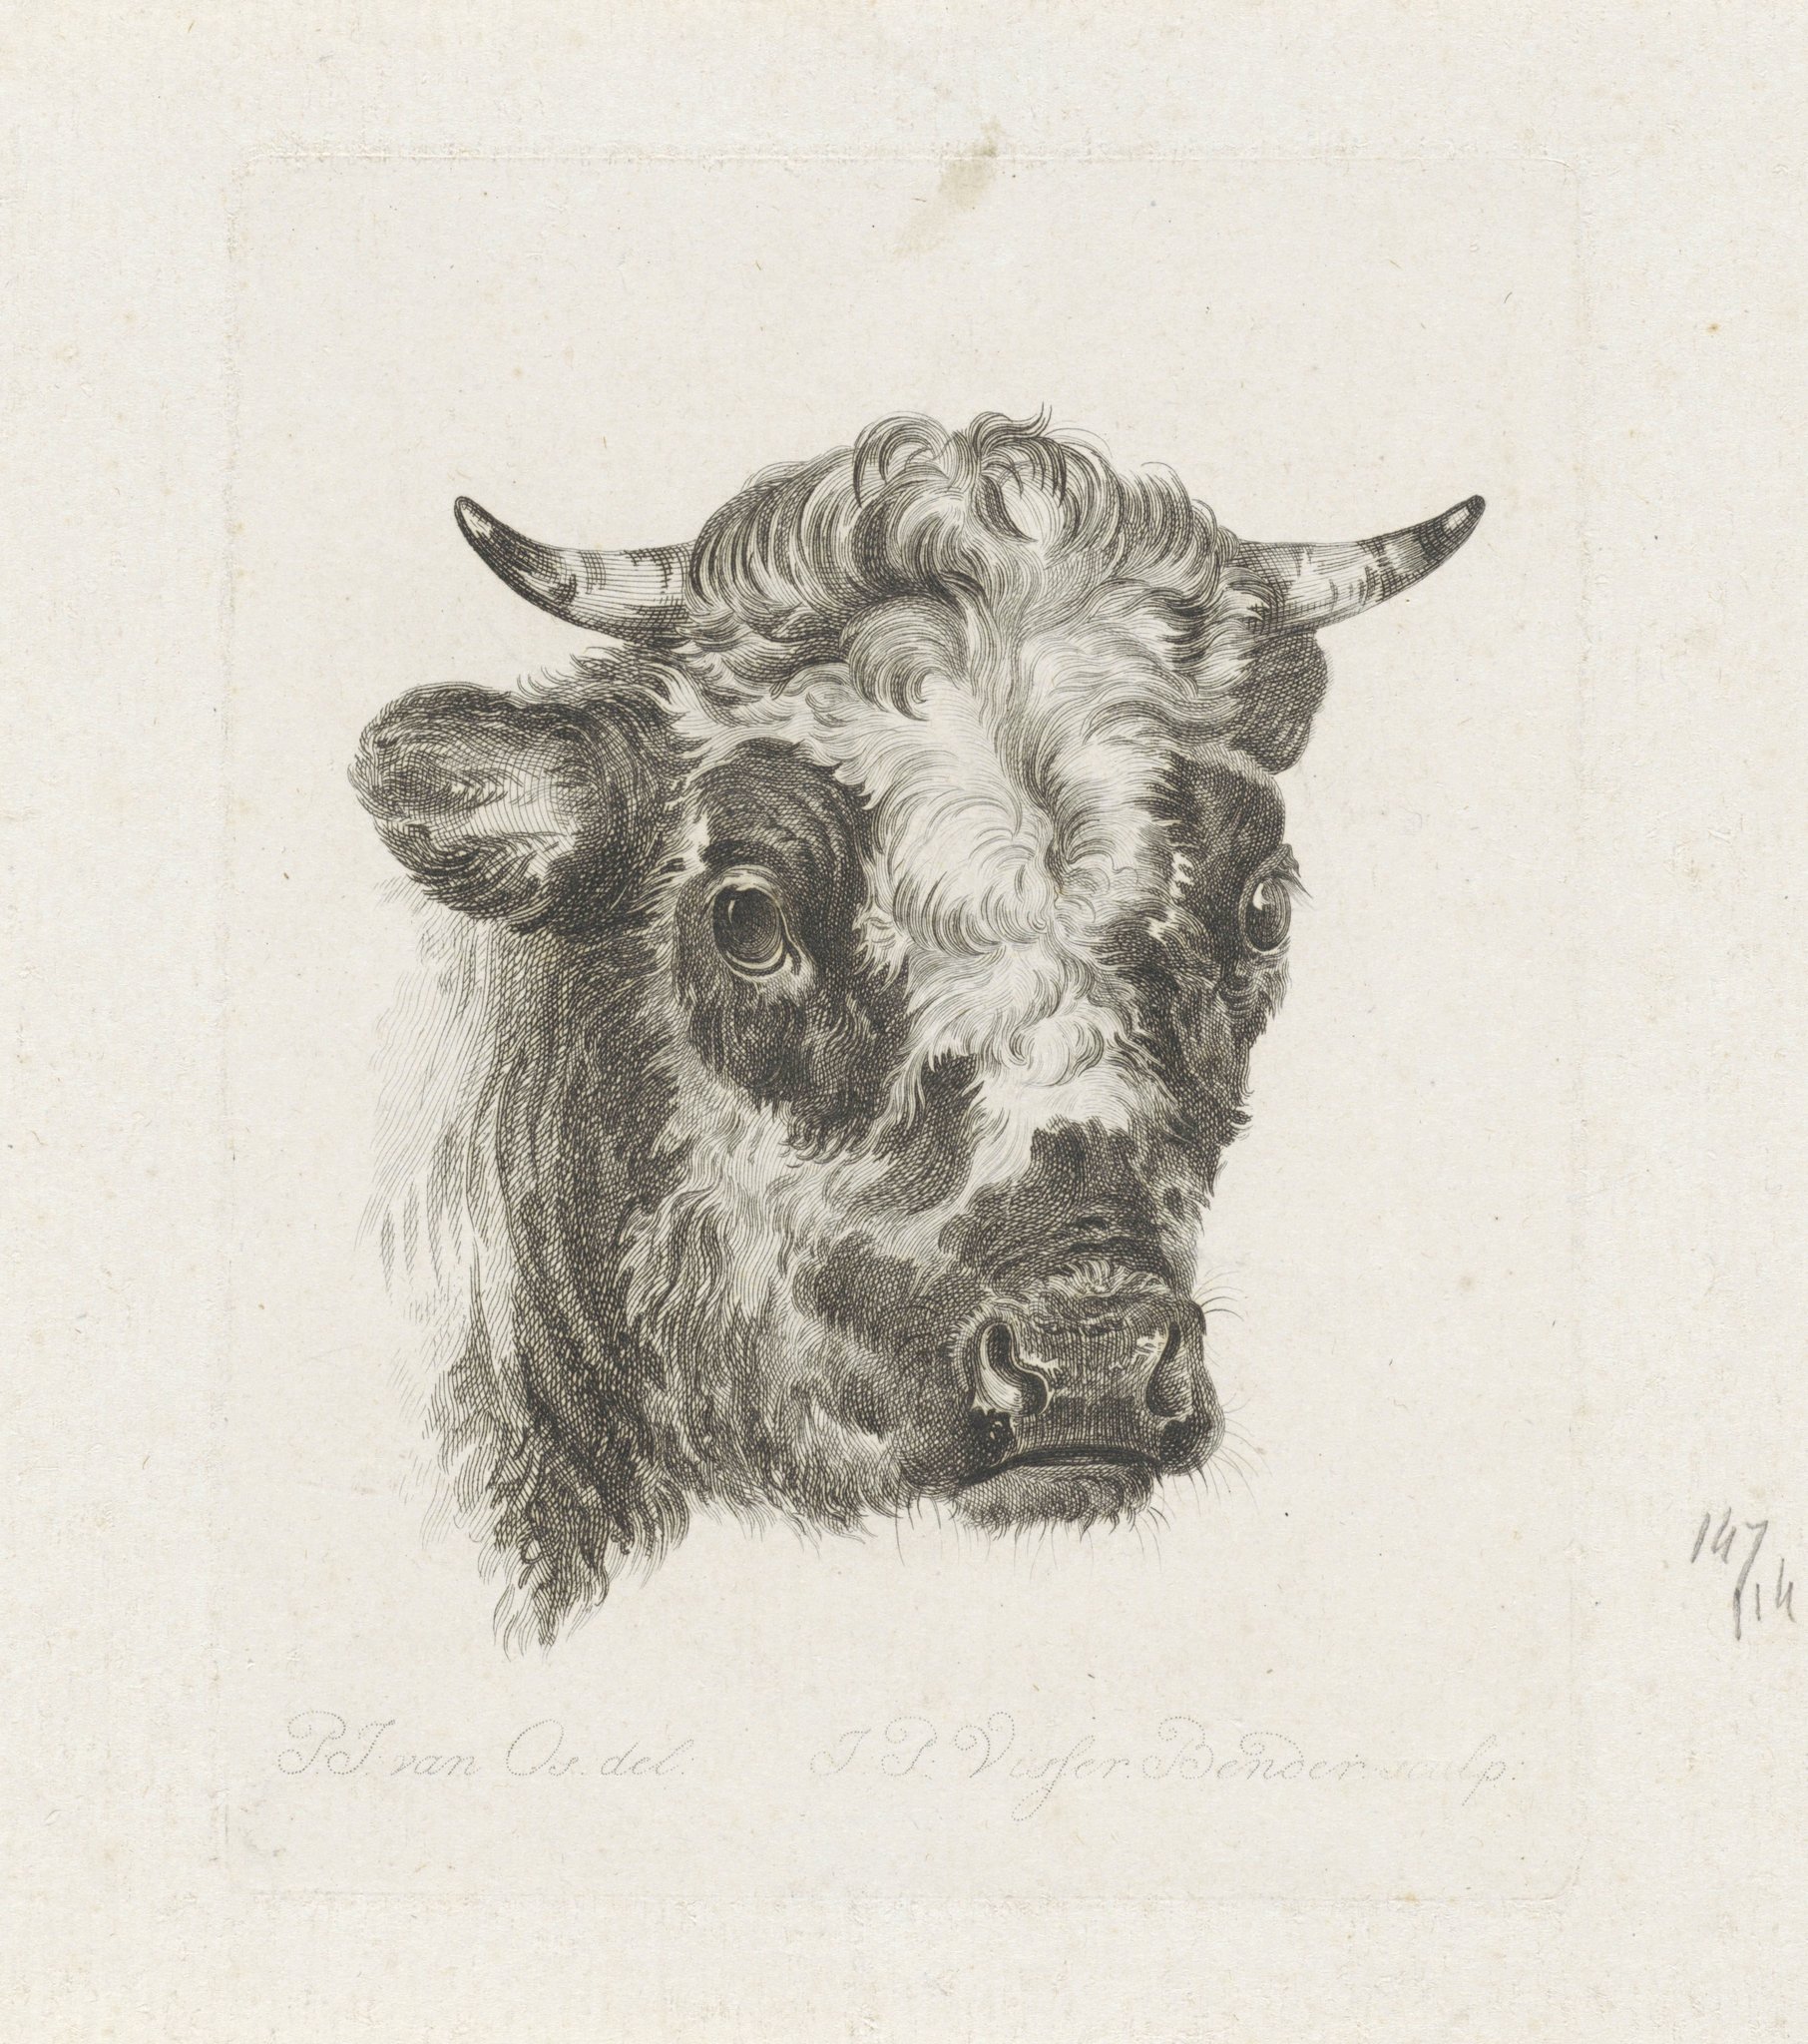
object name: print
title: Portret van Rudolf van Frankrijk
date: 1818-1842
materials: paper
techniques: lithograph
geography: paris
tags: historical persons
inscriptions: collector's mark: Lugt 2228a